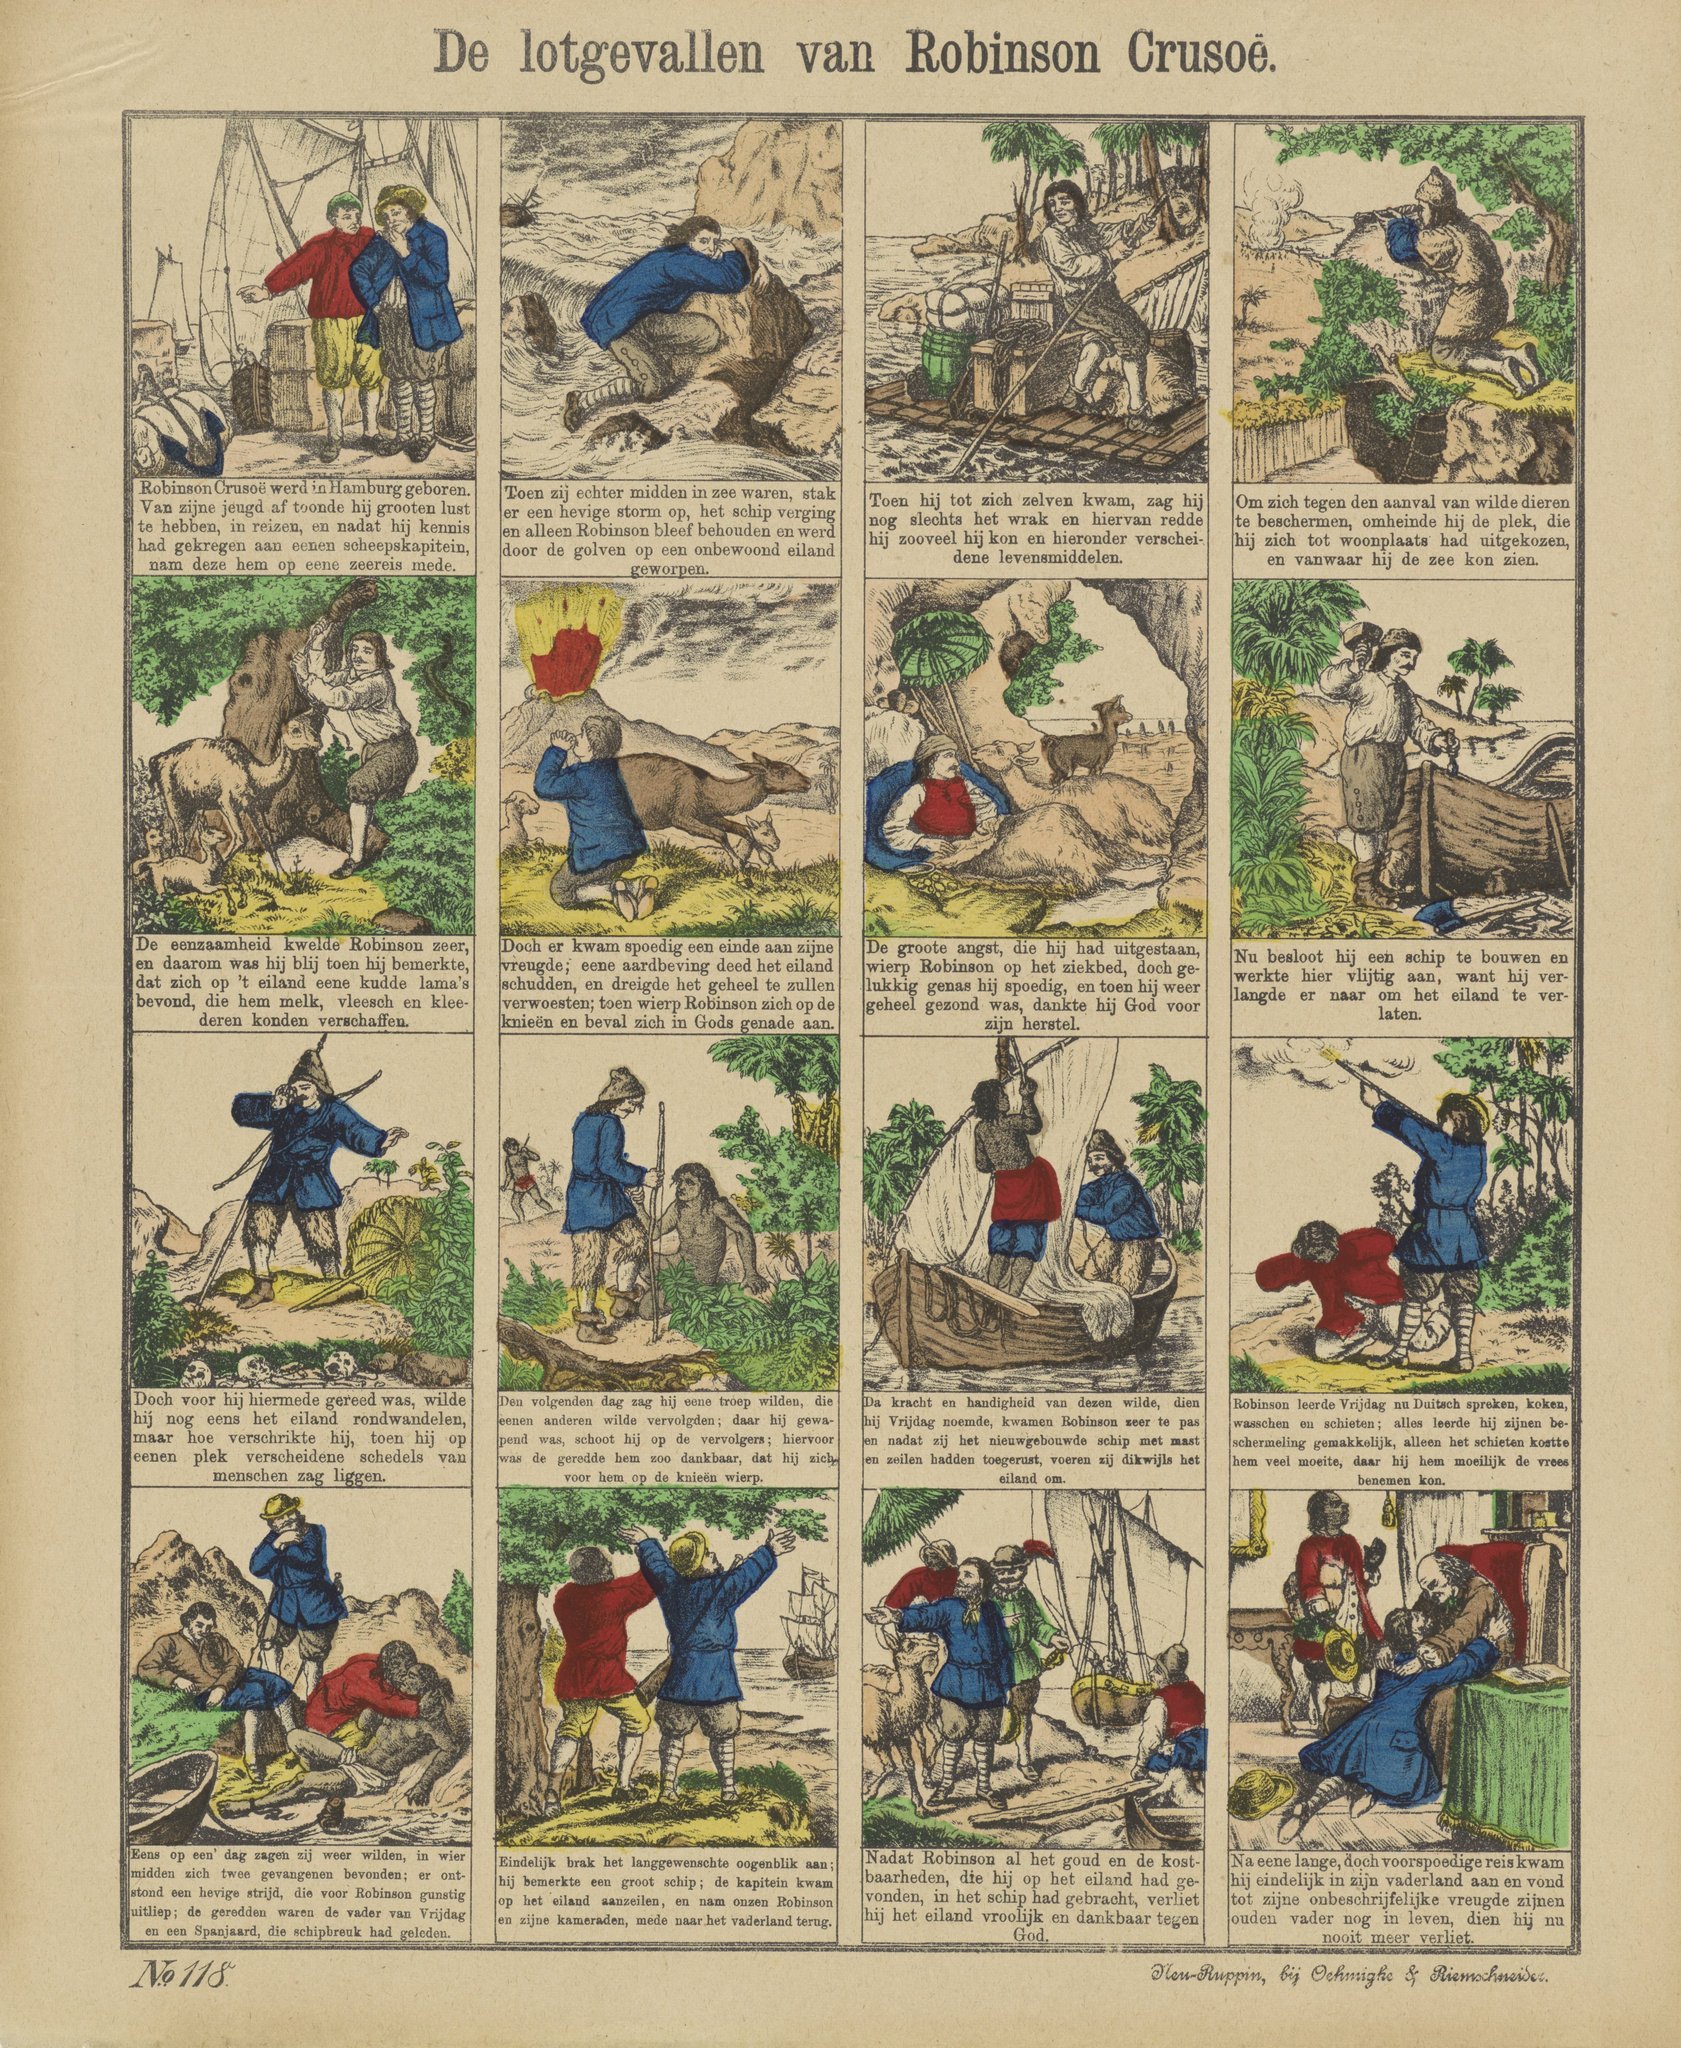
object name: print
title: De lotgevallen van Robinson Crusoë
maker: Anonymous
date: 1828-1937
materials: paper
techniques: hand coloring, letterpress printing, lithograph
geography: neuruppin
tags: (scenes from) specific works of literature: defoe, robinson crusoe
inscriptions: collector's mark: Lugt 2760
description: Blad met 16 voorstellingen uit het verhaal van Robinson Crusoe die strandt op een eiland. Onder elke afbeelding een onderschrift. Genummerd linksonder: No. 118.